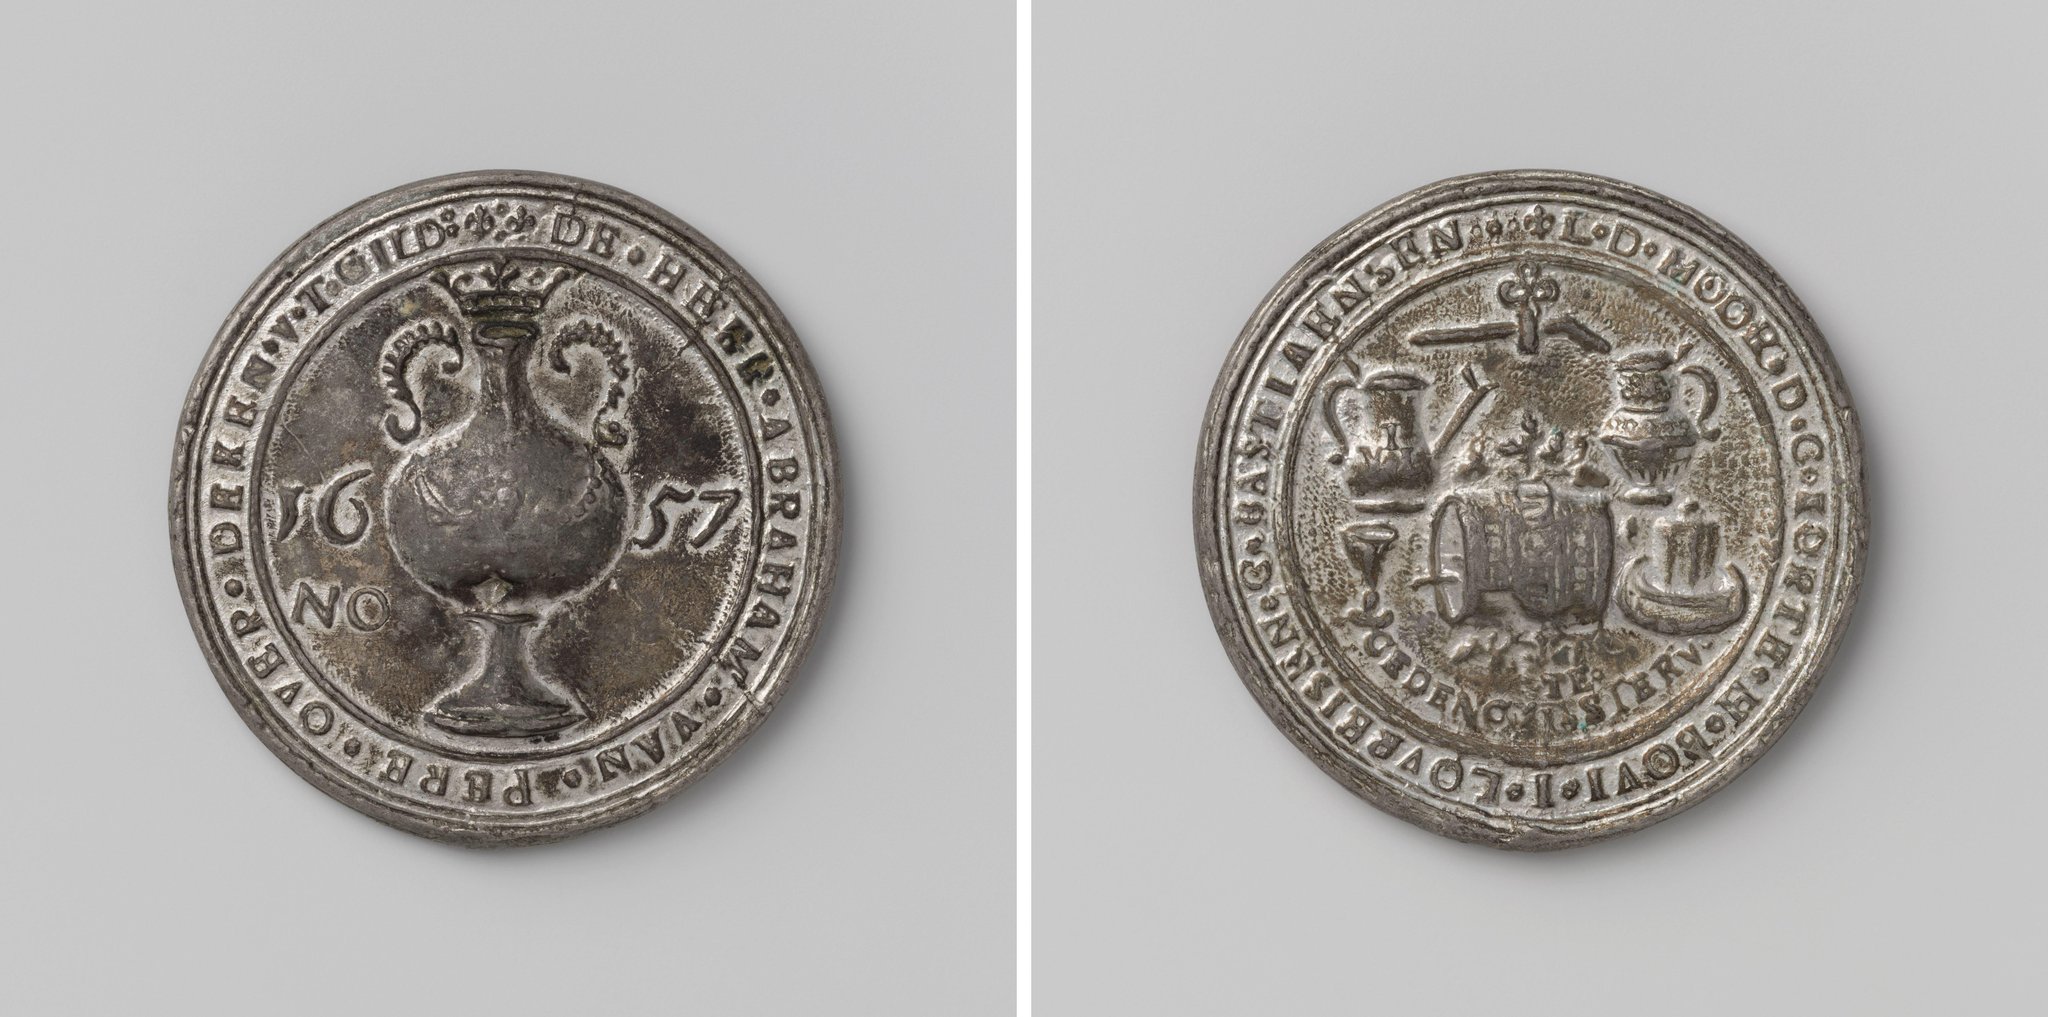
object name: medal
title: Tappersgilde van Vlissingen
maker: Anonymous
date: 1657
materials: lead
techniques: casting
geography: flushing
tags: abraham van pere, flushing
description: Loden penning. Voorzijde: gekroonde fles tussen jaartal en opschrift binnen omschrift. Keerzijde: vat op tap, omringd door loofwerk; daaromheen: tuitkan met opschrift, wijnglas, kan met een oor en schotel waarop bierglas boven opschrift binnen omschrift.